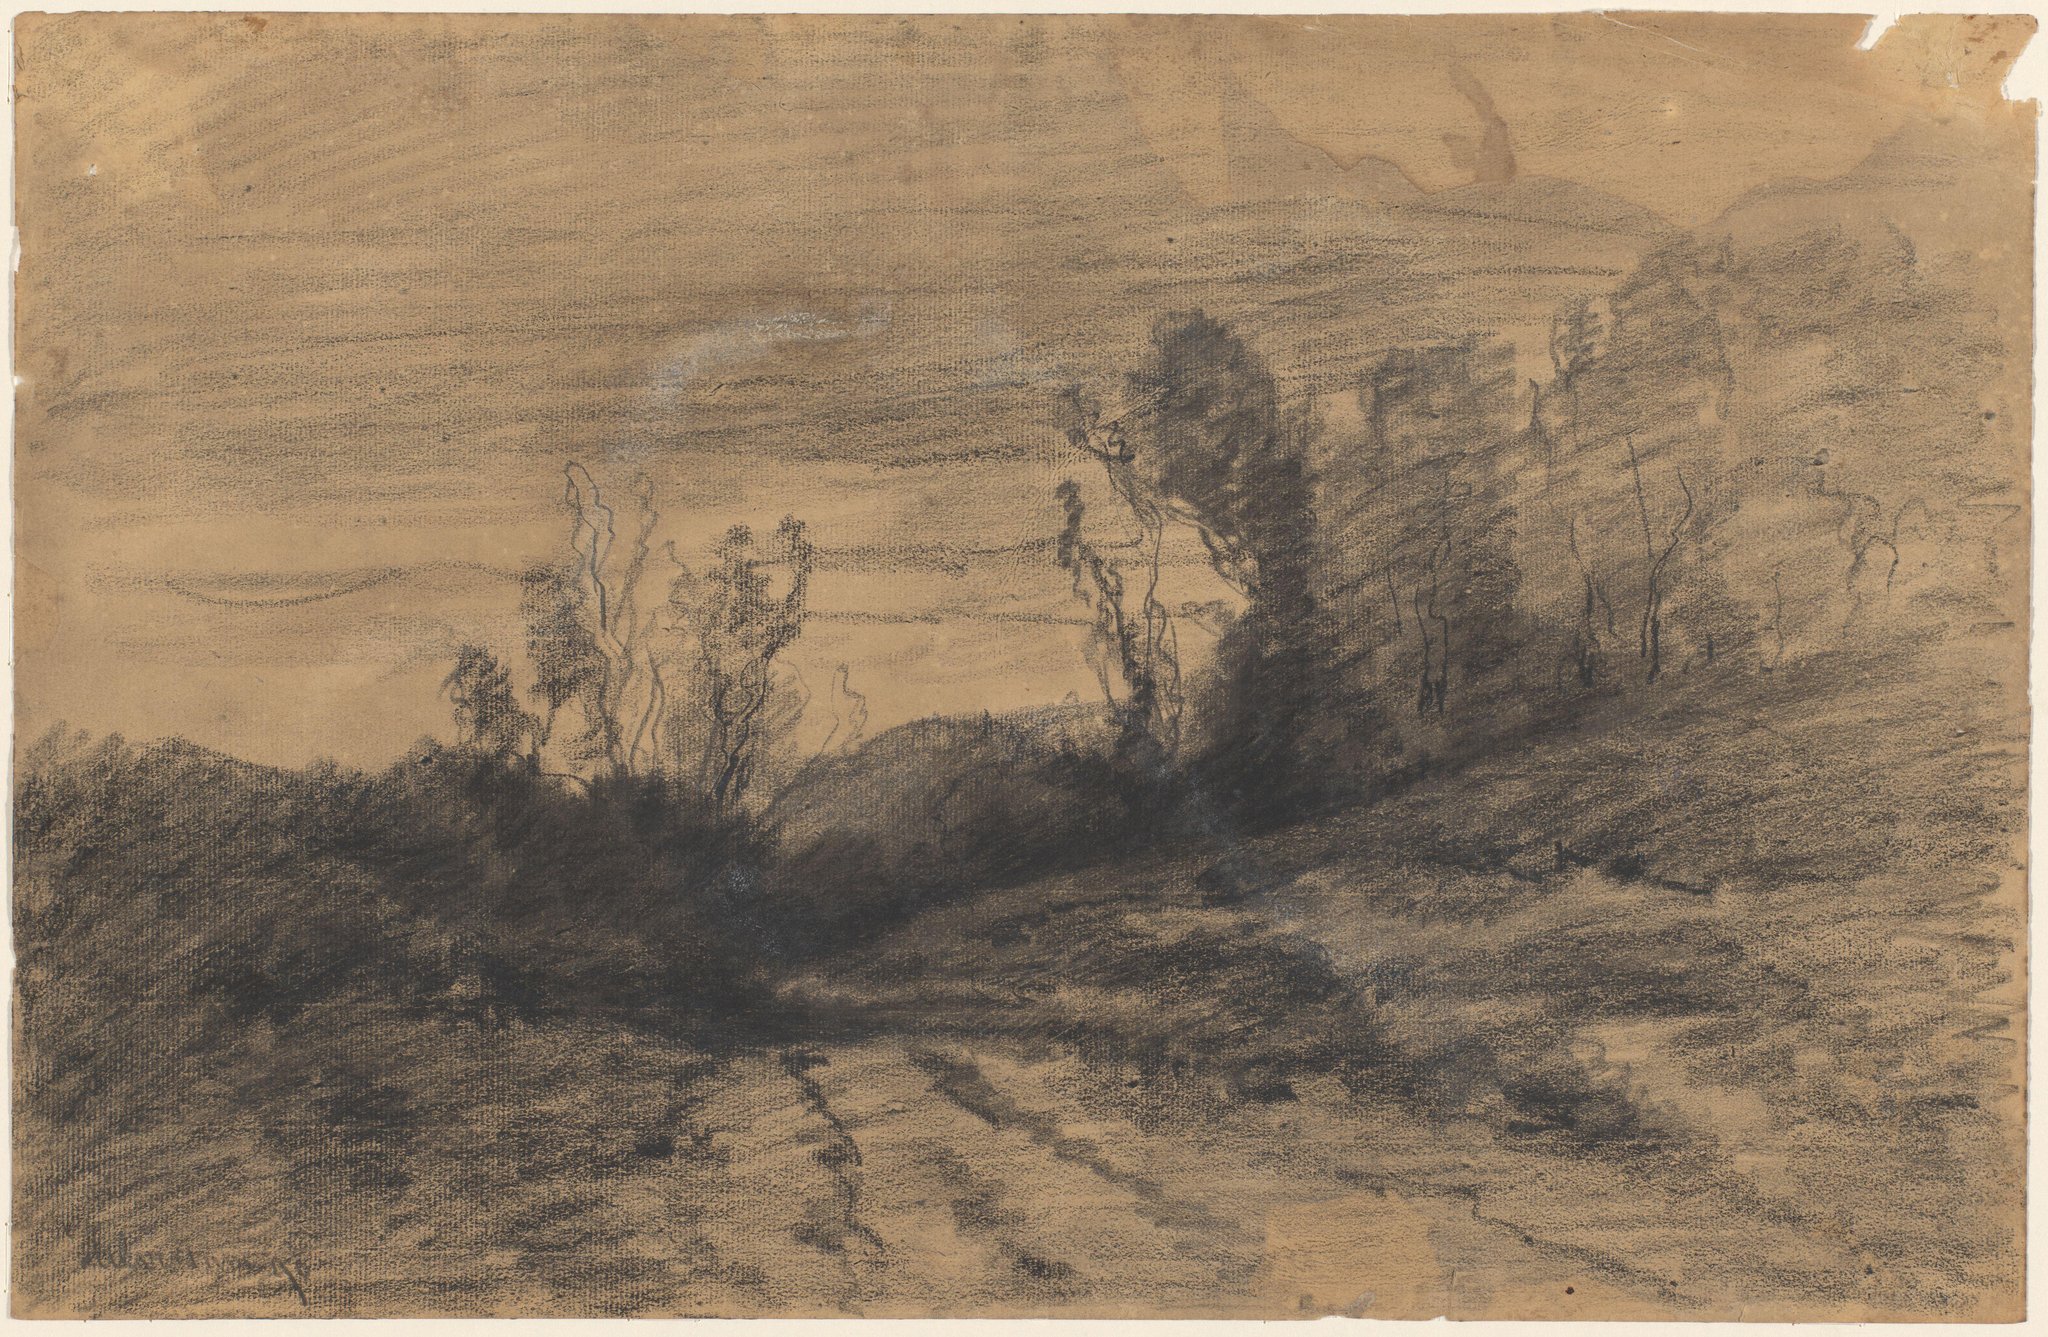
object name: drawing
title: Landschap te Hilversum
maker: johannes gijsbert vogel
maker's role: draughtsman, painter, print maker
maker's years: 1828-1915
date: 1890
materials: chalk, paper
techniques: brush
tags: landscapes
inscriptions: date and inscription: ‘Hilversum 90’, collector's mark: Lugt 1181b